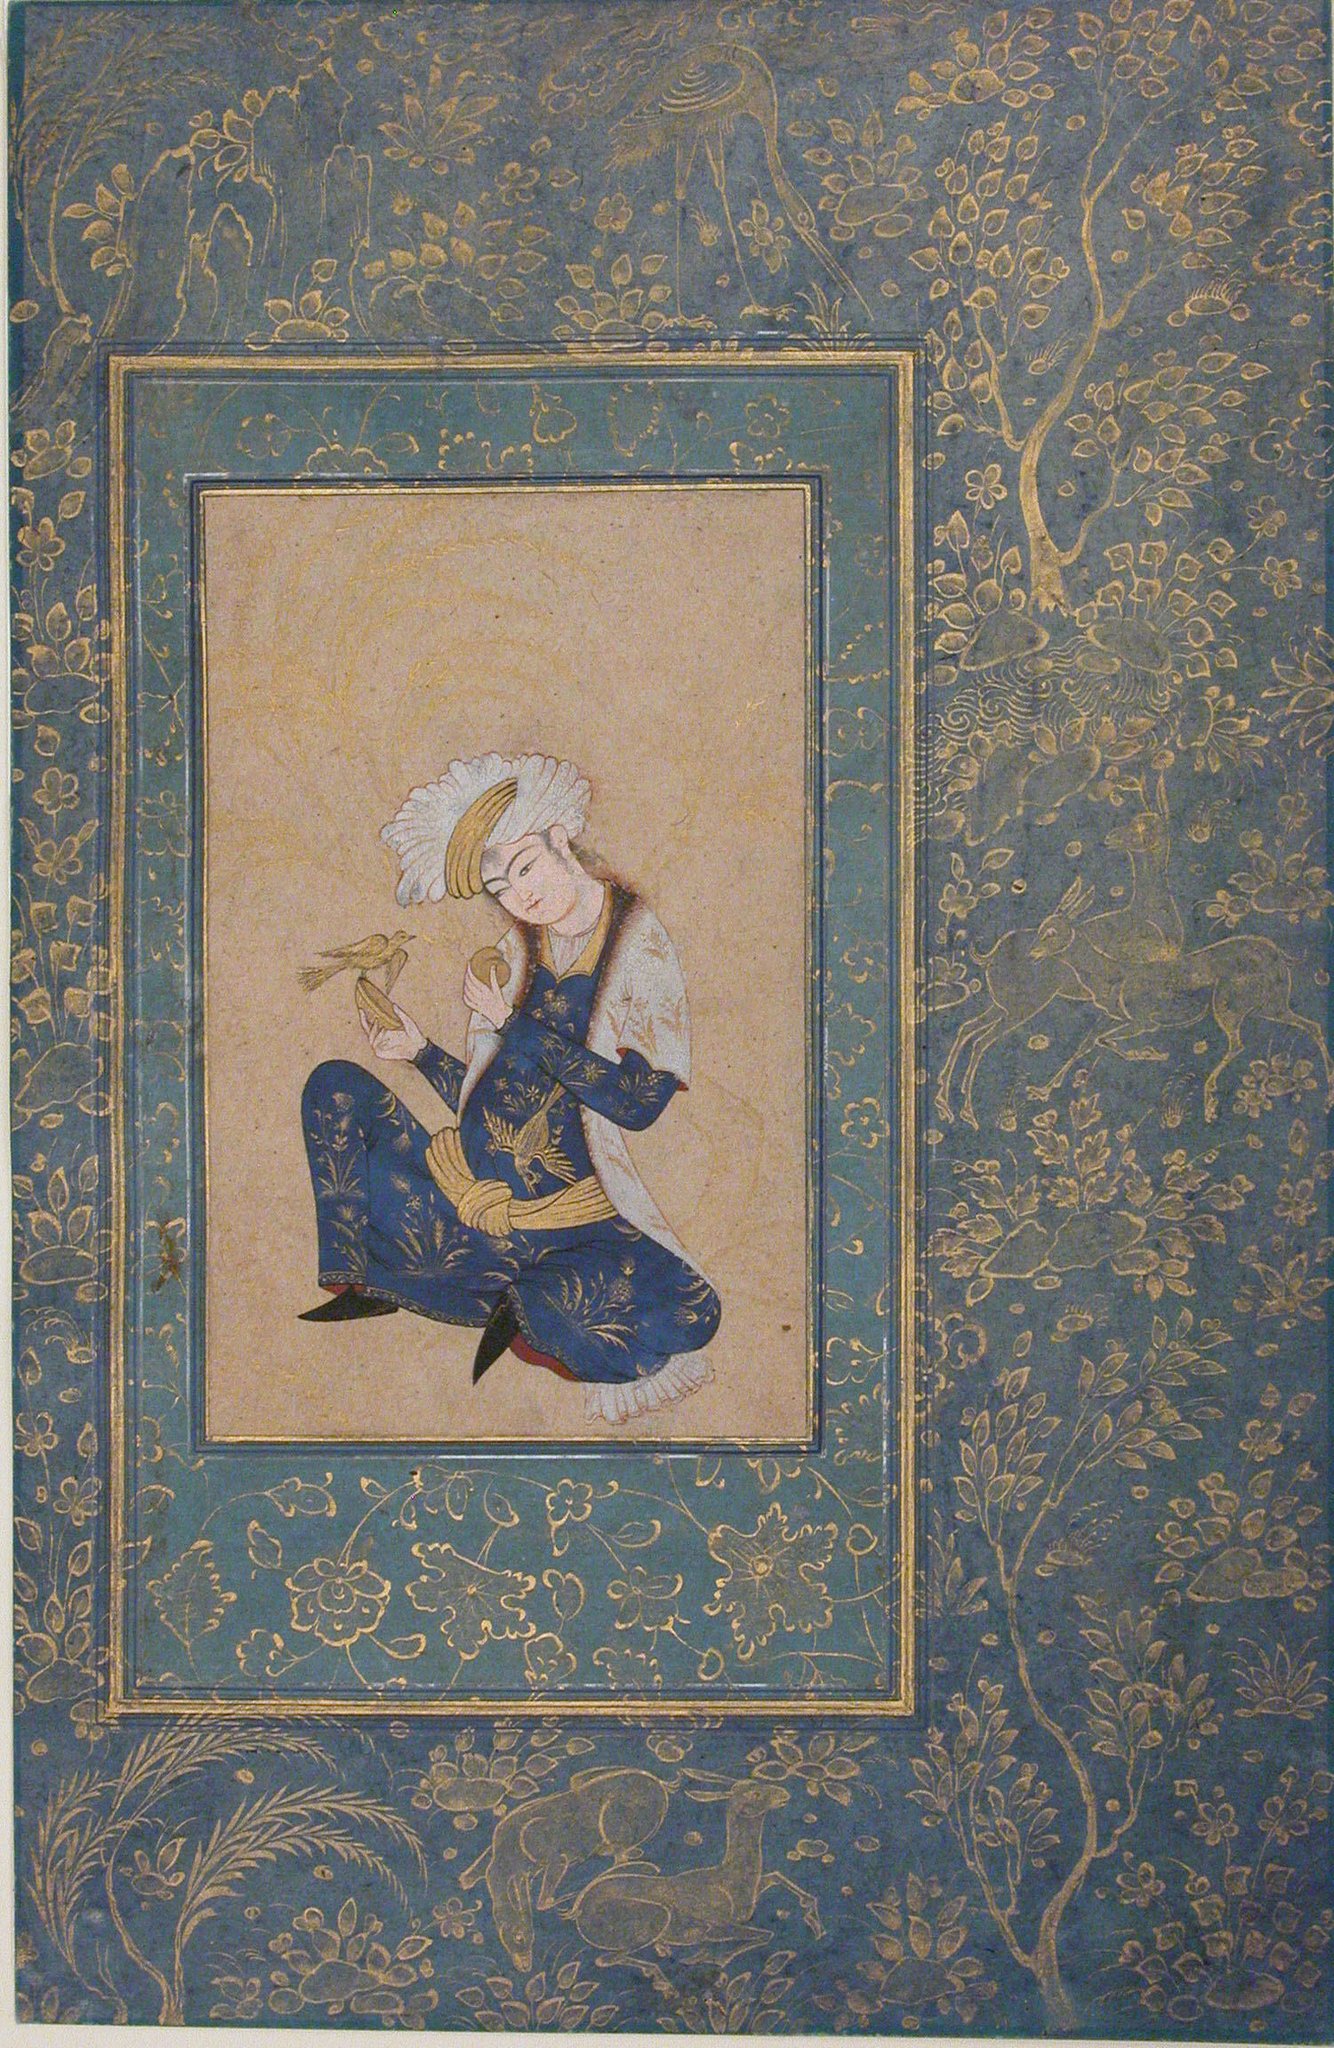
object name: illustrated album leaf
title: Portrait of a Youth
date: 1567-1600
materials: gold, paper, watercolor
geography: iran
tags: birds,men,portraits